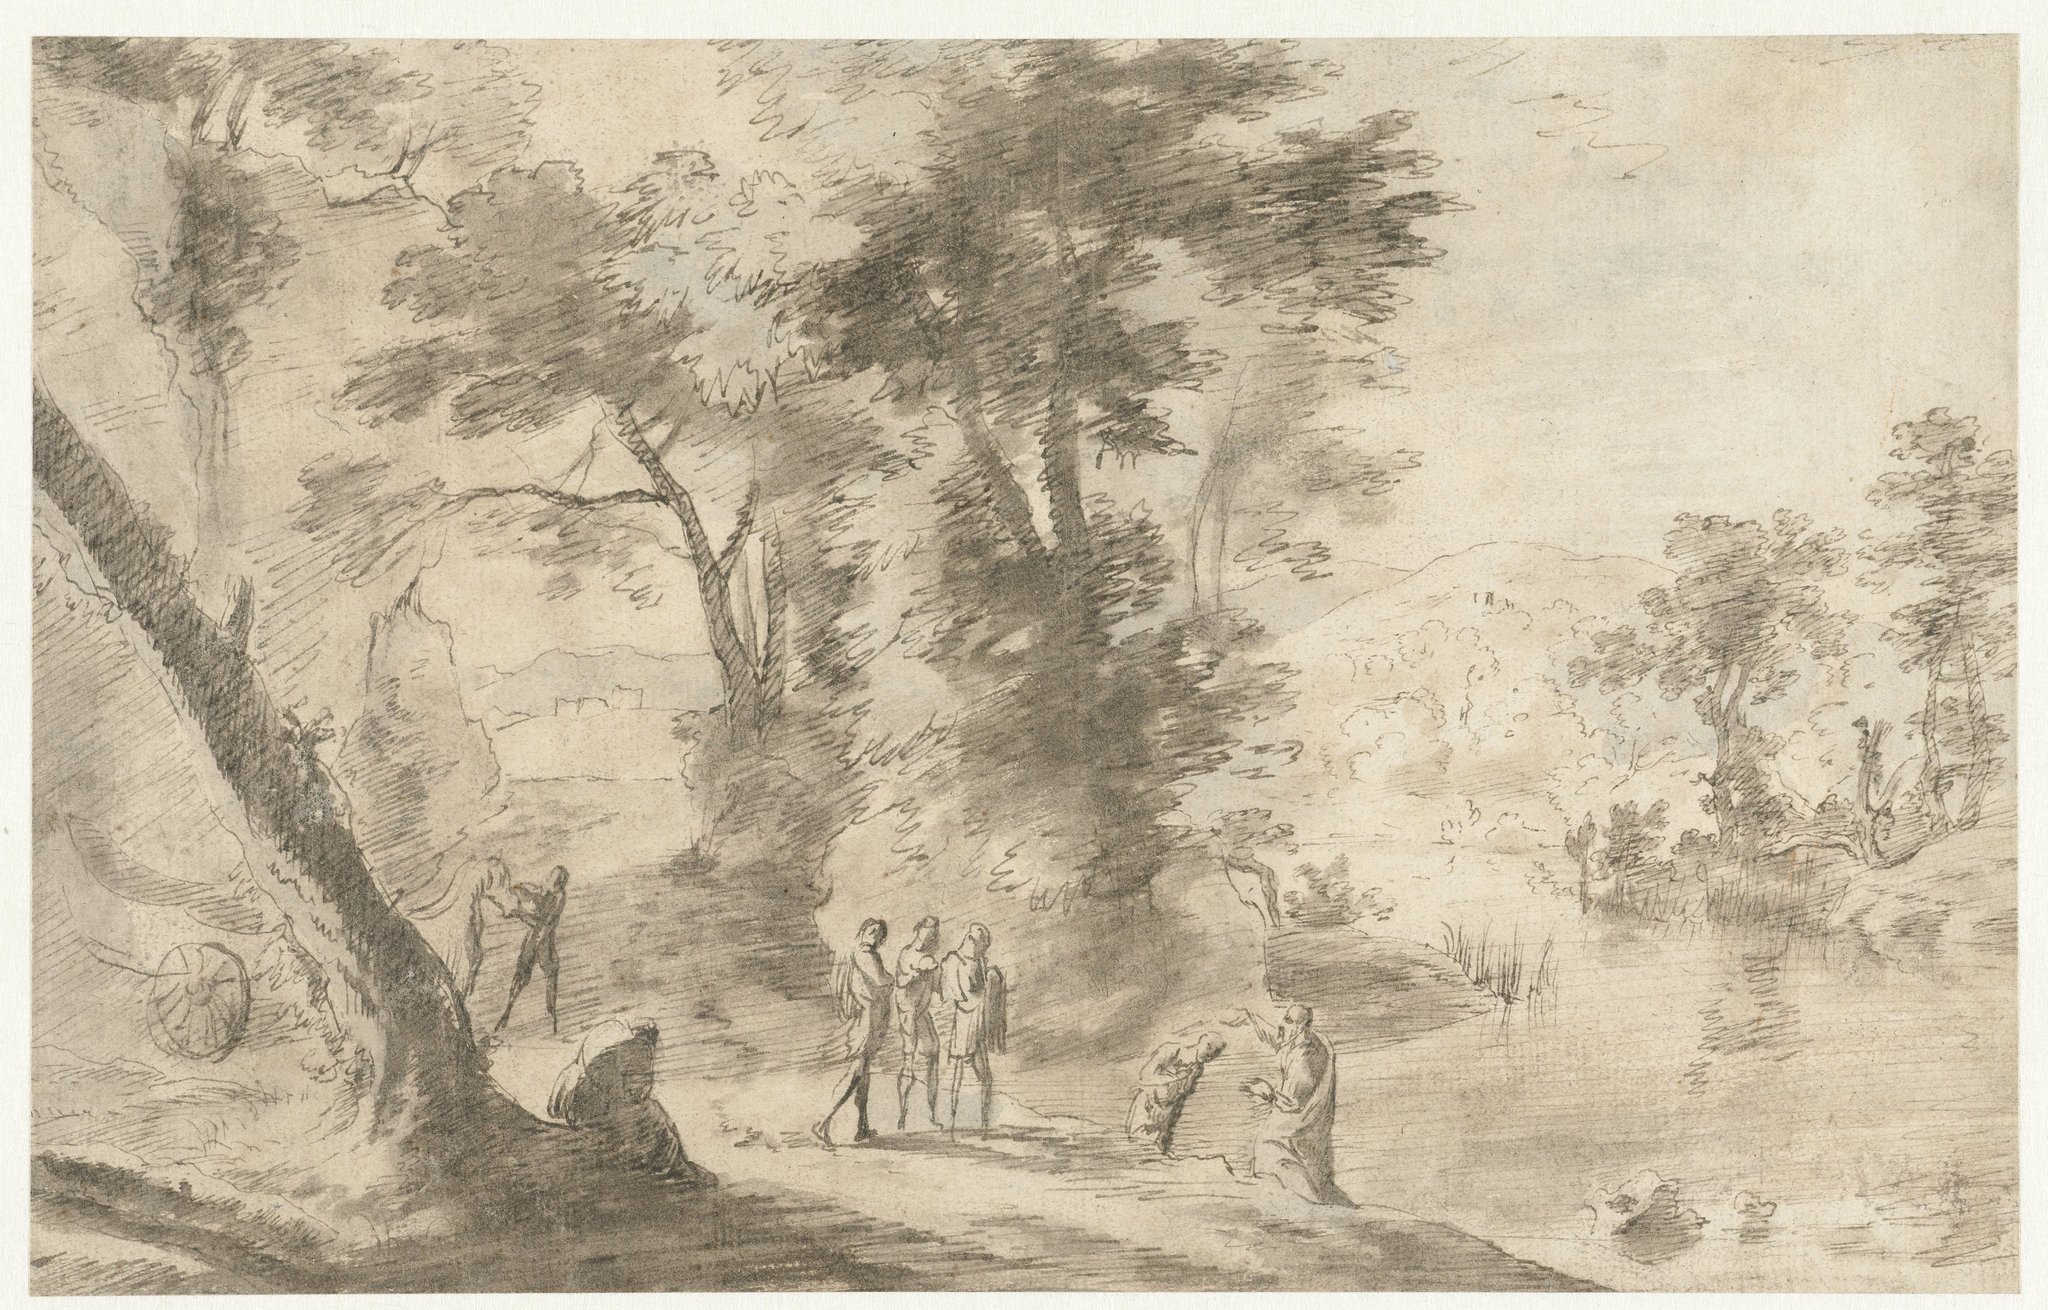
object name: drawing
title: Landschap met de doop van de kamerling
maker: herman van swanevelt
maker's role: draughtsman, painter, print maker, publisher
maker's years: 1603-1655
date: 1630-1639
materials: ink, paper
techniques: brush, pen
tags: philip baptizes the eunuch, river bank